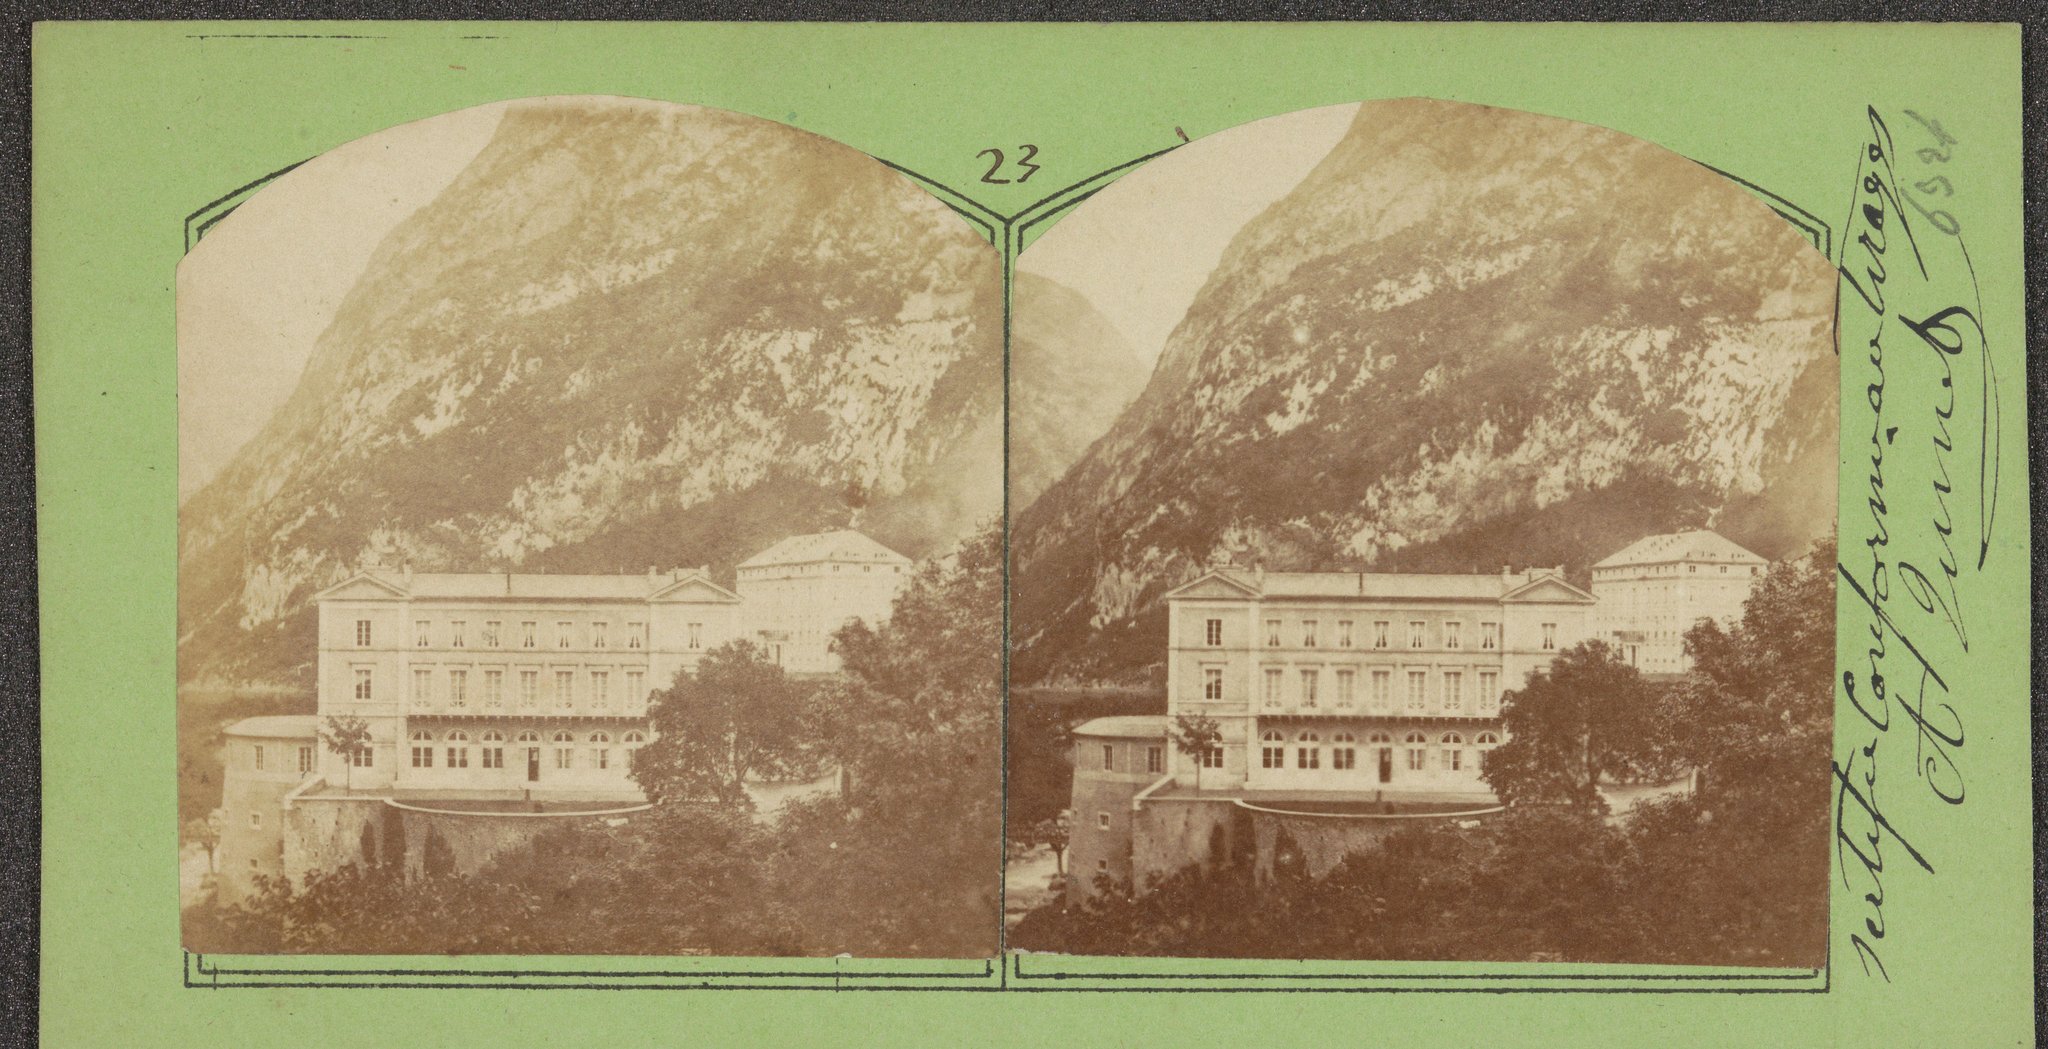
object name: stereograph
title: Groot gebouw aan de voet van de Alpen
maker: achille quinet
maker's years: 1831-1900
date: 1860-1880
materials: cardboard, paper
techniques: albumen print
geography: alps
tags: mountains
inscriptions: signature: ‘Sertifier conforme au tirages // A Quinet’